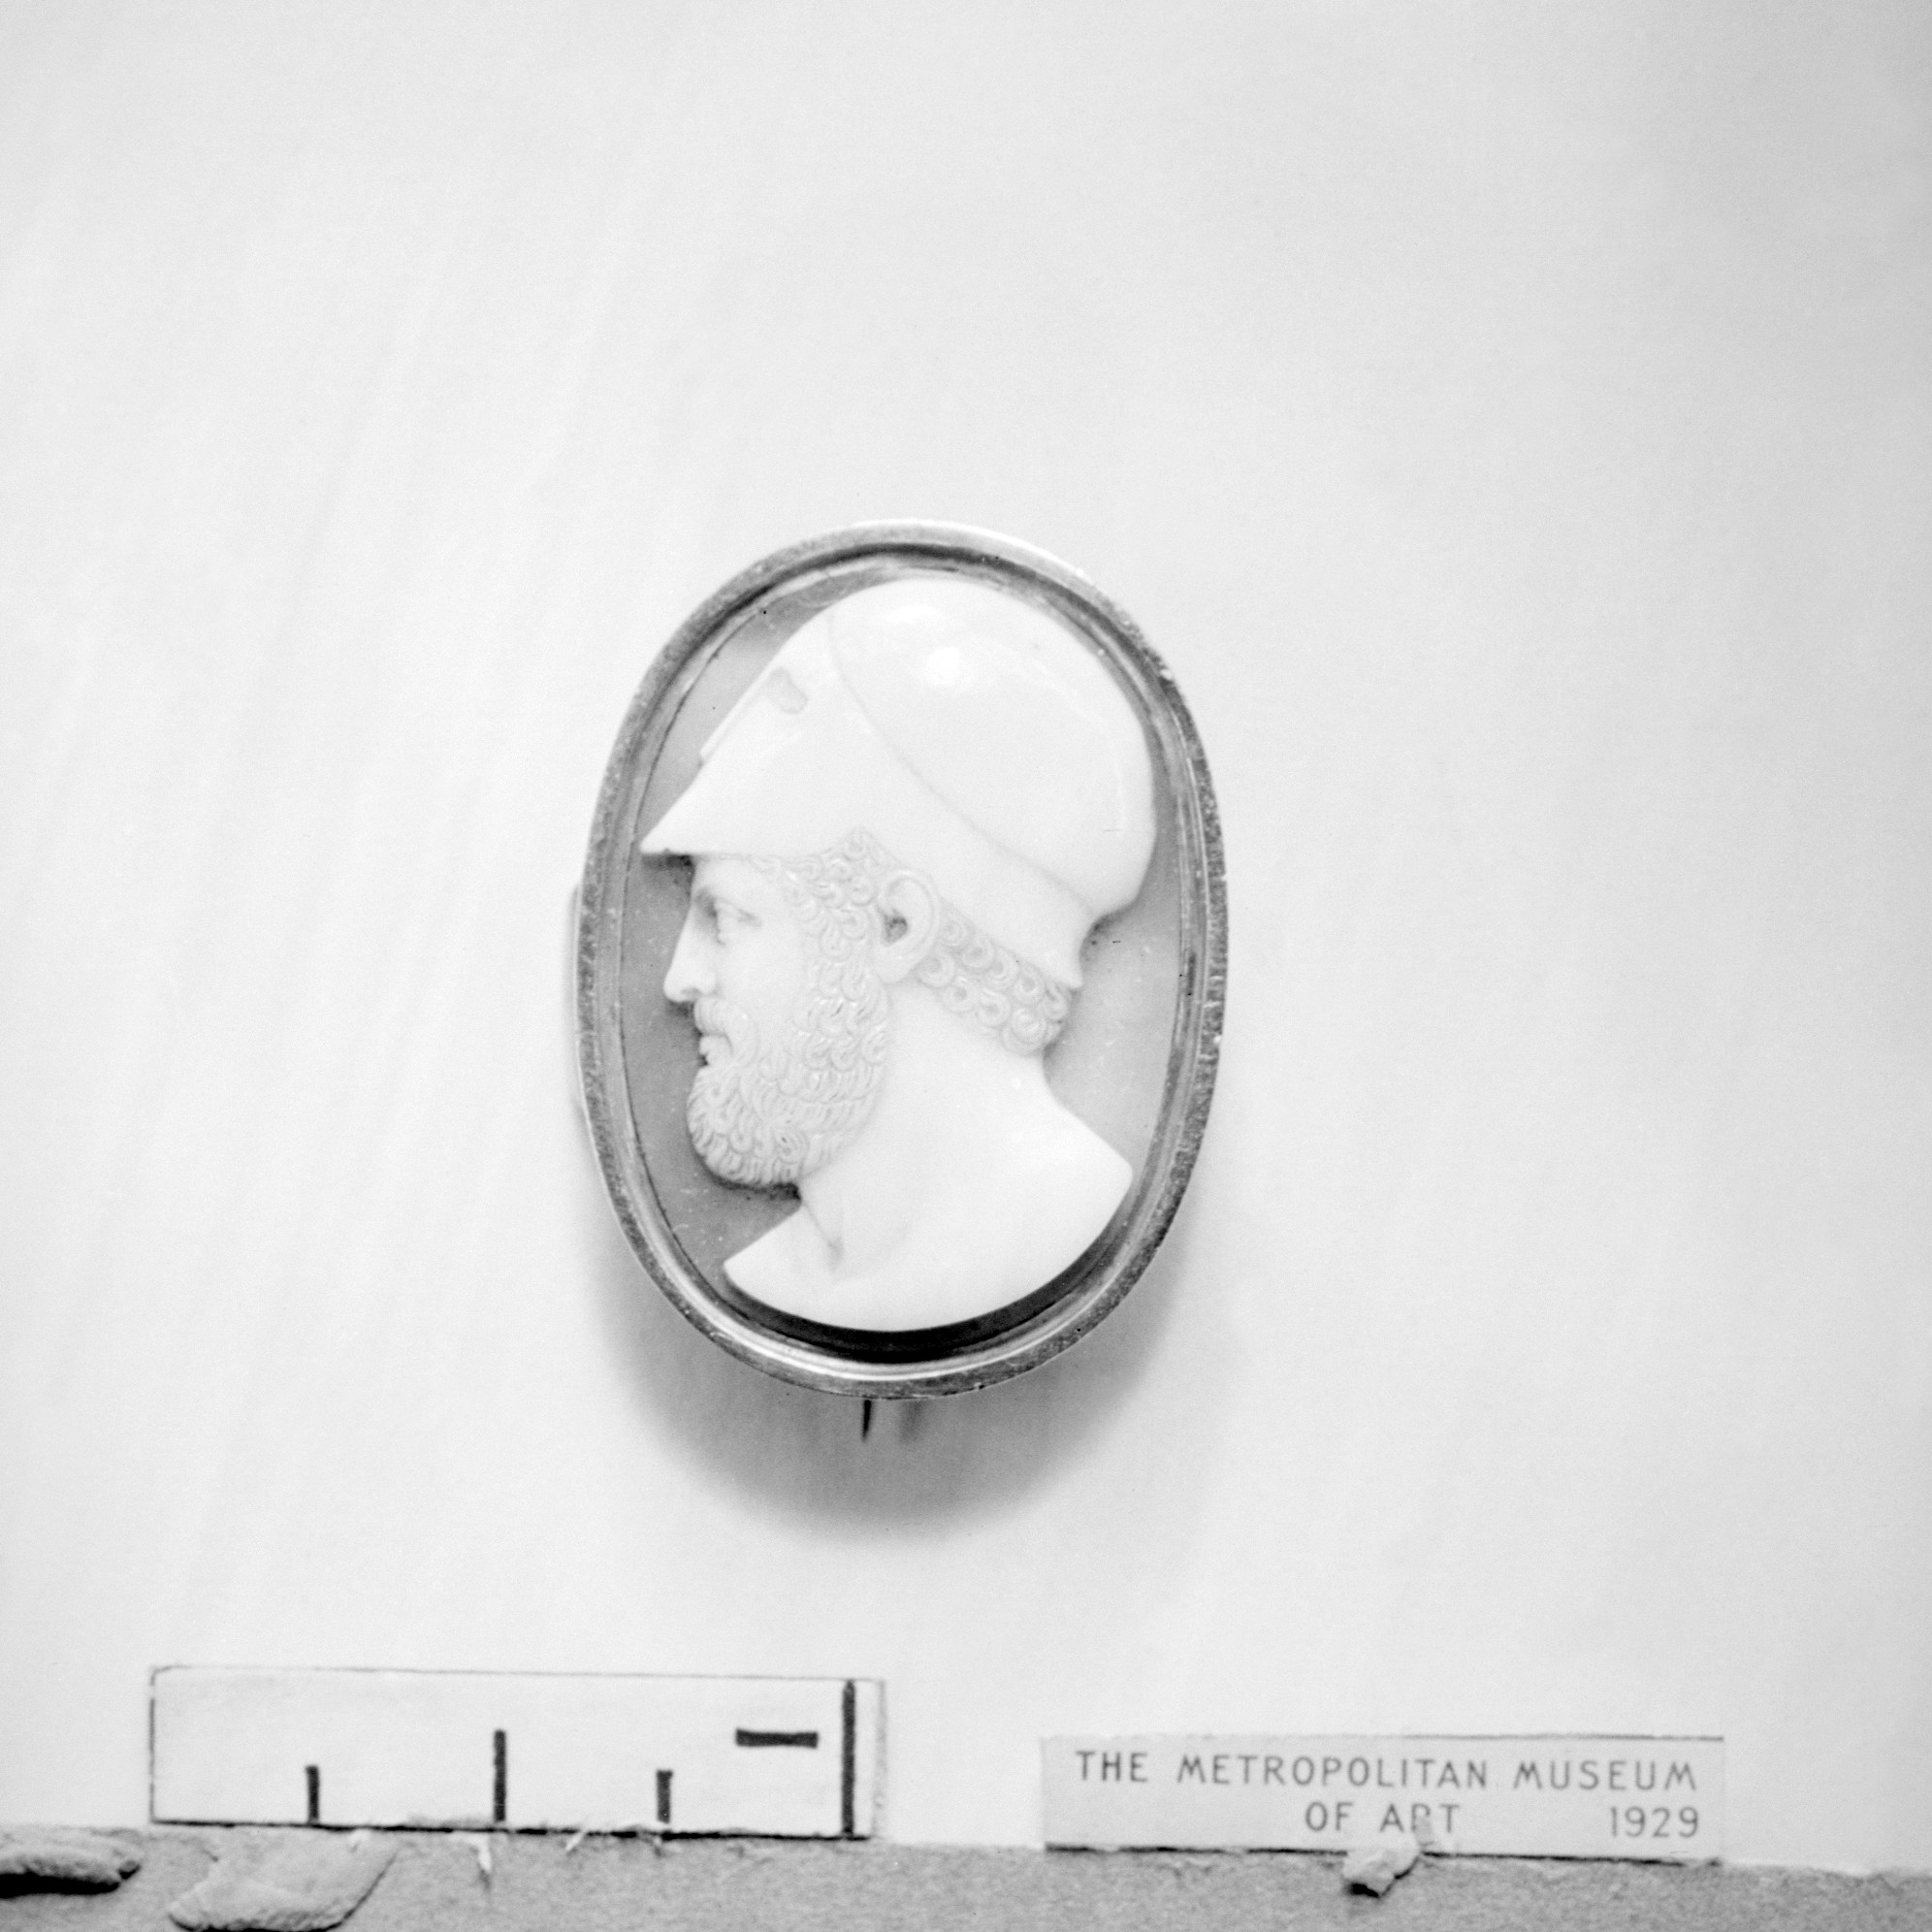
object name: cameo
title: Head of Pericles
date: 1801-1900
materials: gold, onyx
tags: heads,men,profiles